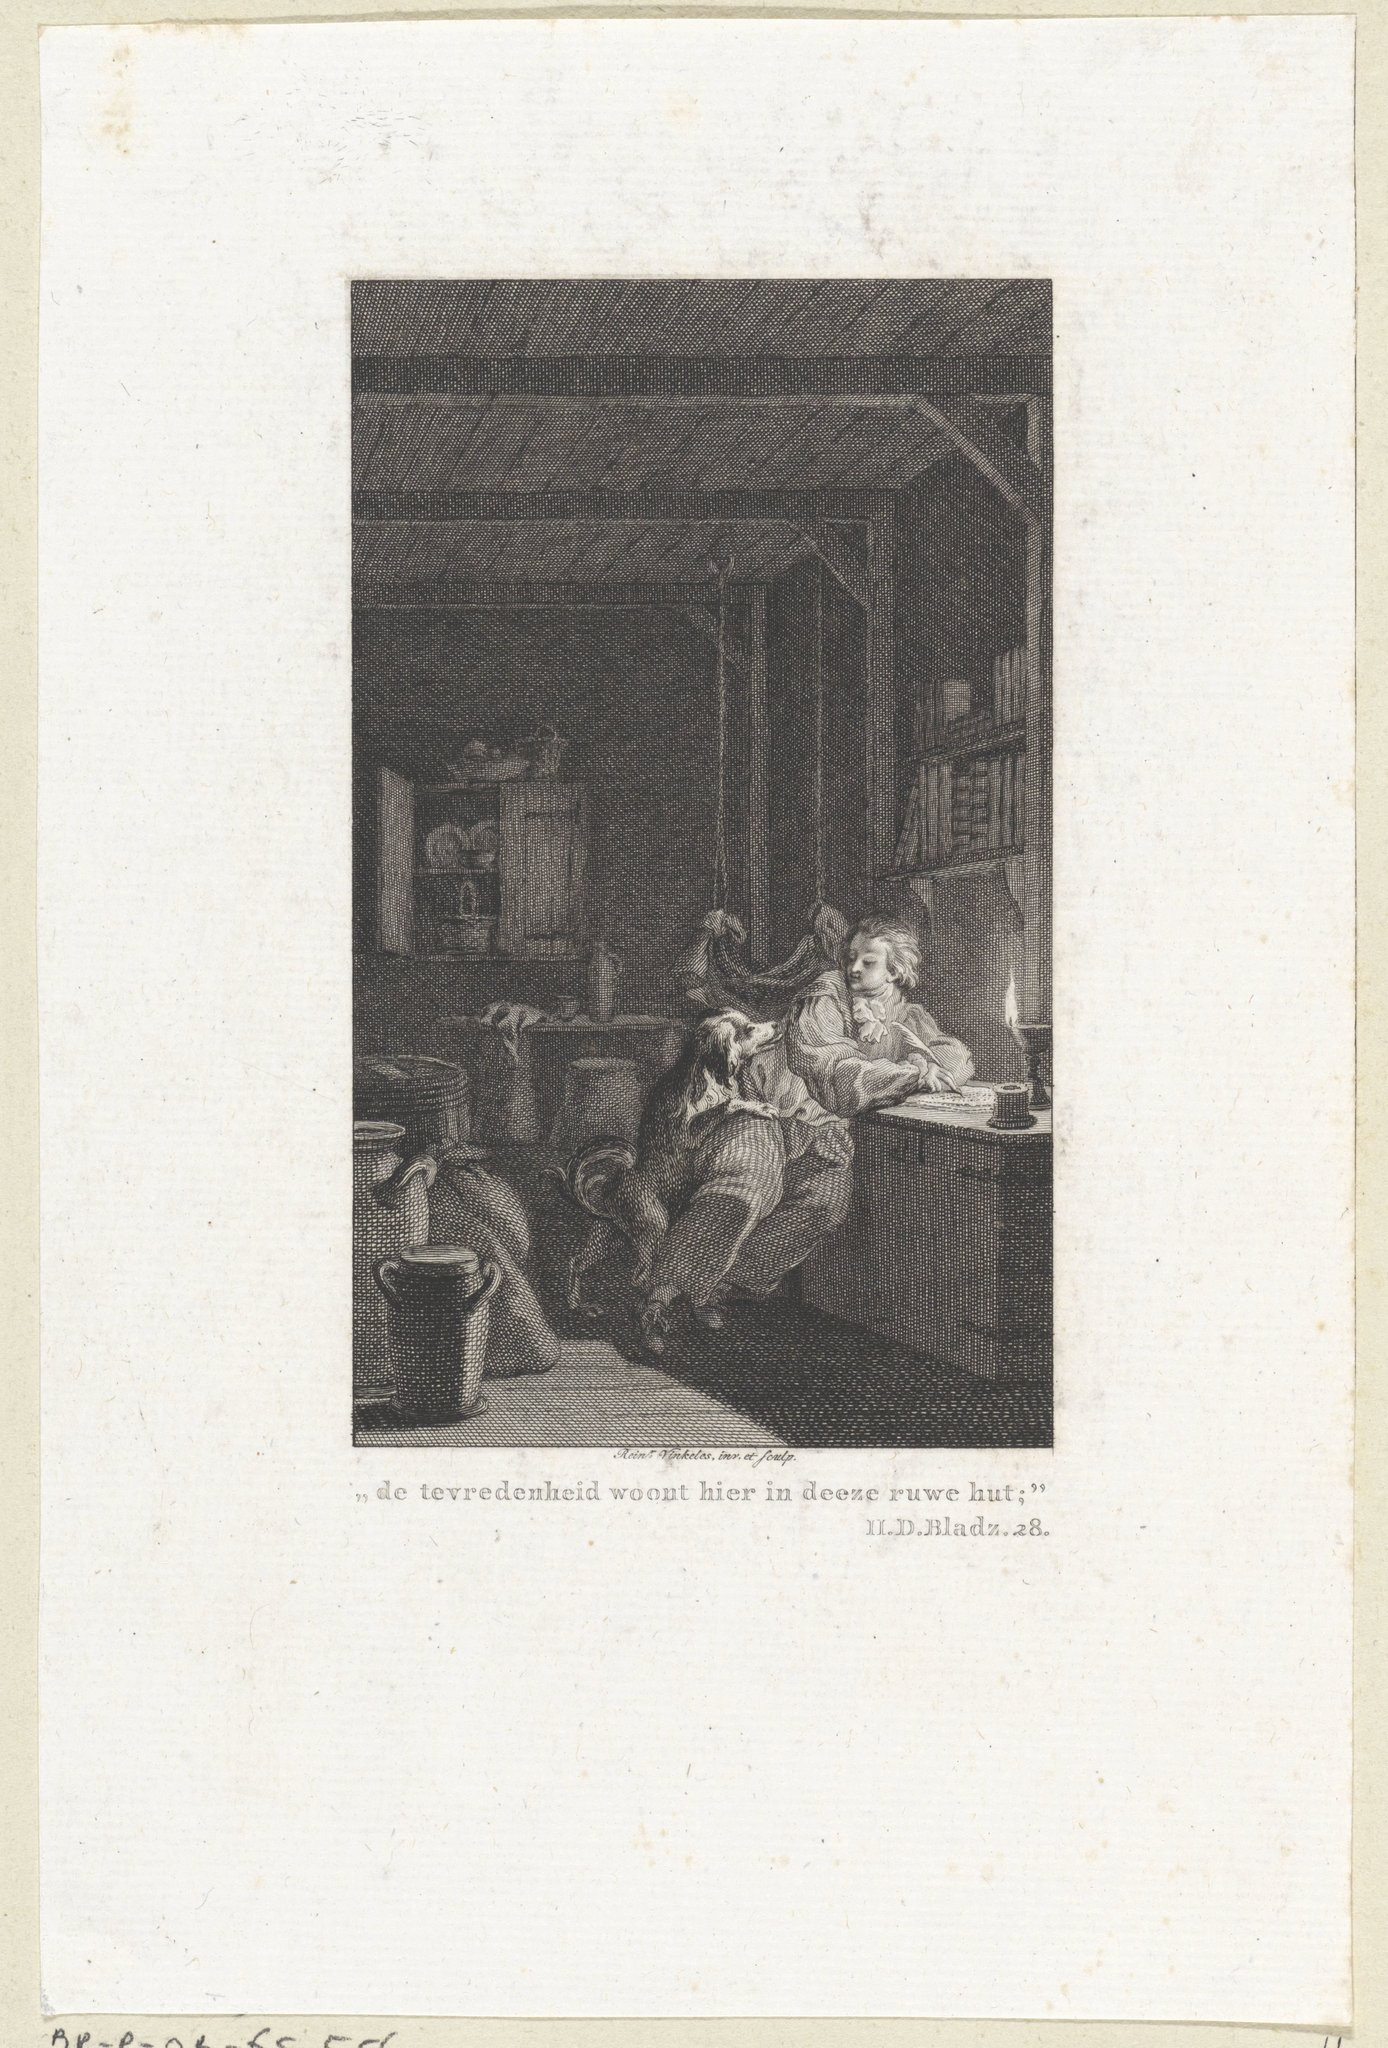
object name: print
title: Terwijl Reinhart bij kaarslicht zit te schrijven komt zijn hond bij hem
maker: reinier vinkeles (i)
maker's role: draughtsman, print maker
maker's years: 1741-1816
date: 1791-1798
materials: paper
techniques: engraving, etching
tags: handwriting, writing as activity, lighting; lamps, dog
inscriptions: collector's mark: Lugt 240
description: Prent gebruikt in: Post, Elisabeth Maria. Reinhart, of Natuur en Godsdienst. 3 dln. 1e druk. Amsterdam: Johannes Allart, 1791-1792, dl. 2 (1791), p. 28. En in: Post, Elisabeth Maria. Reinhart, of Natuur en Godsdienst. 3 dln. 2e druk. Amsterdam: Johannes Allart, 1798-1802, dl. 2 (1798), p. 28.